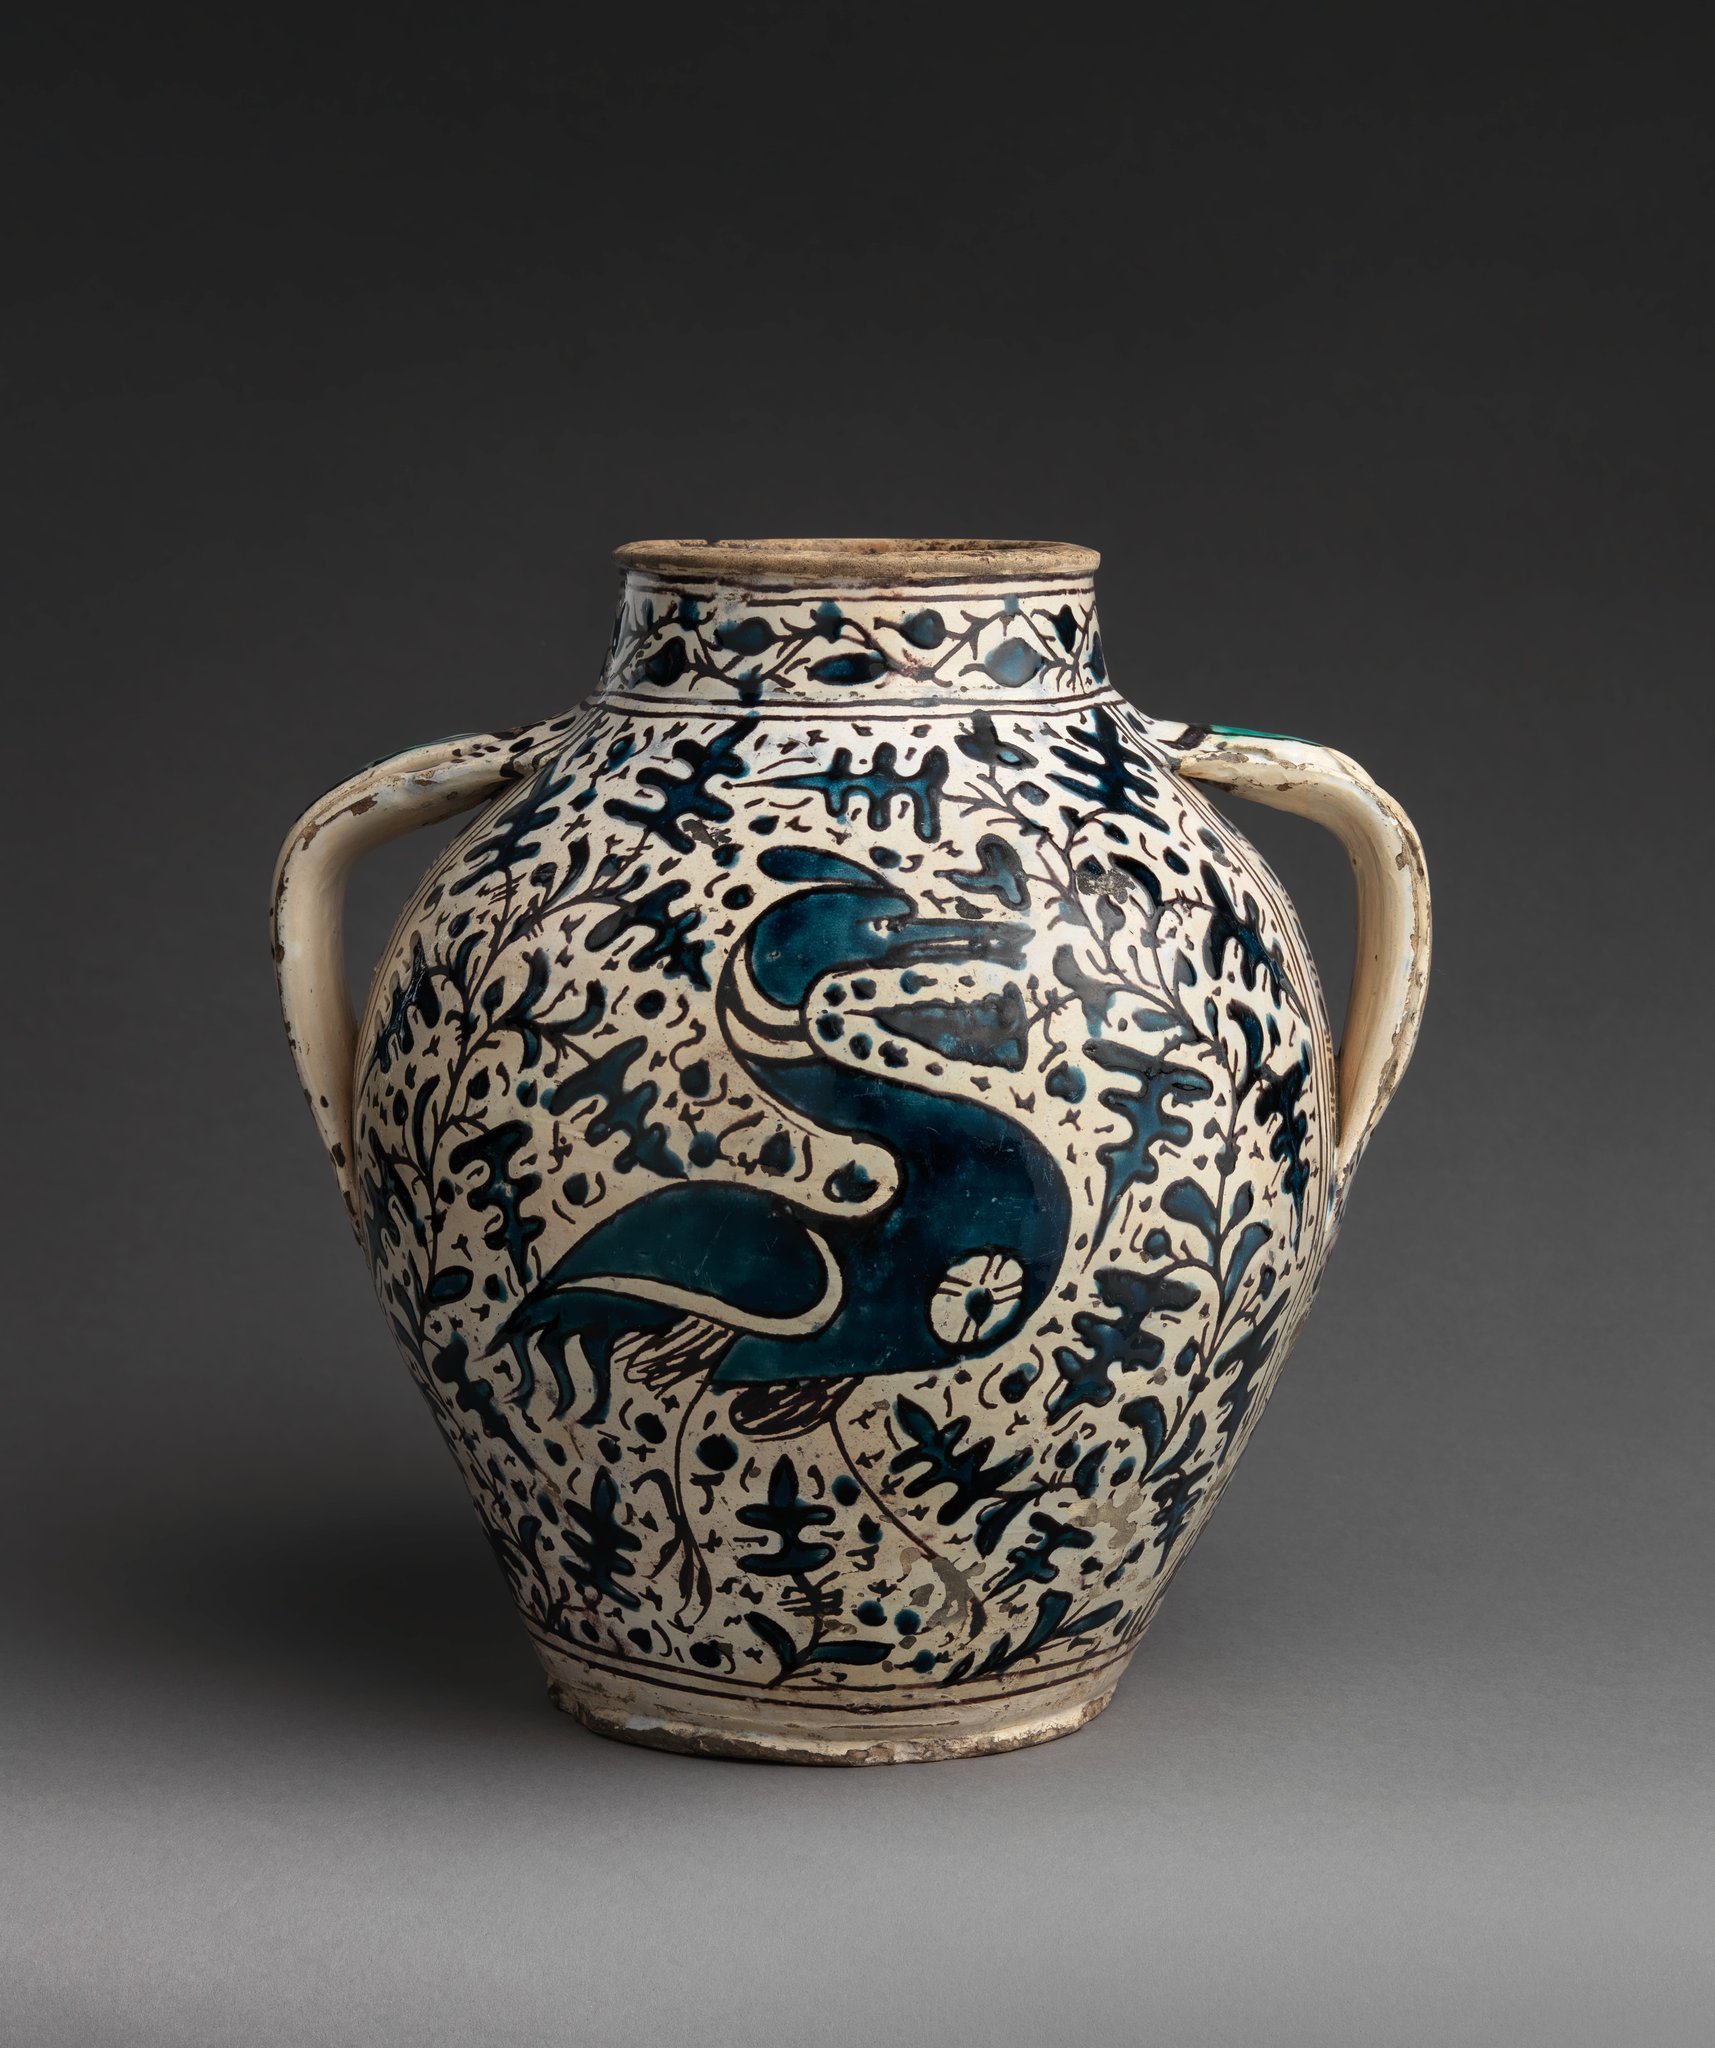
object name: apothecary jar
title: Apothecary jar (orciuolo)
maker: giunta di tugio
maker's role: artist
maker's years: 1400-1466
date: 1431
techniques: maiolica, glazing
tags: birds